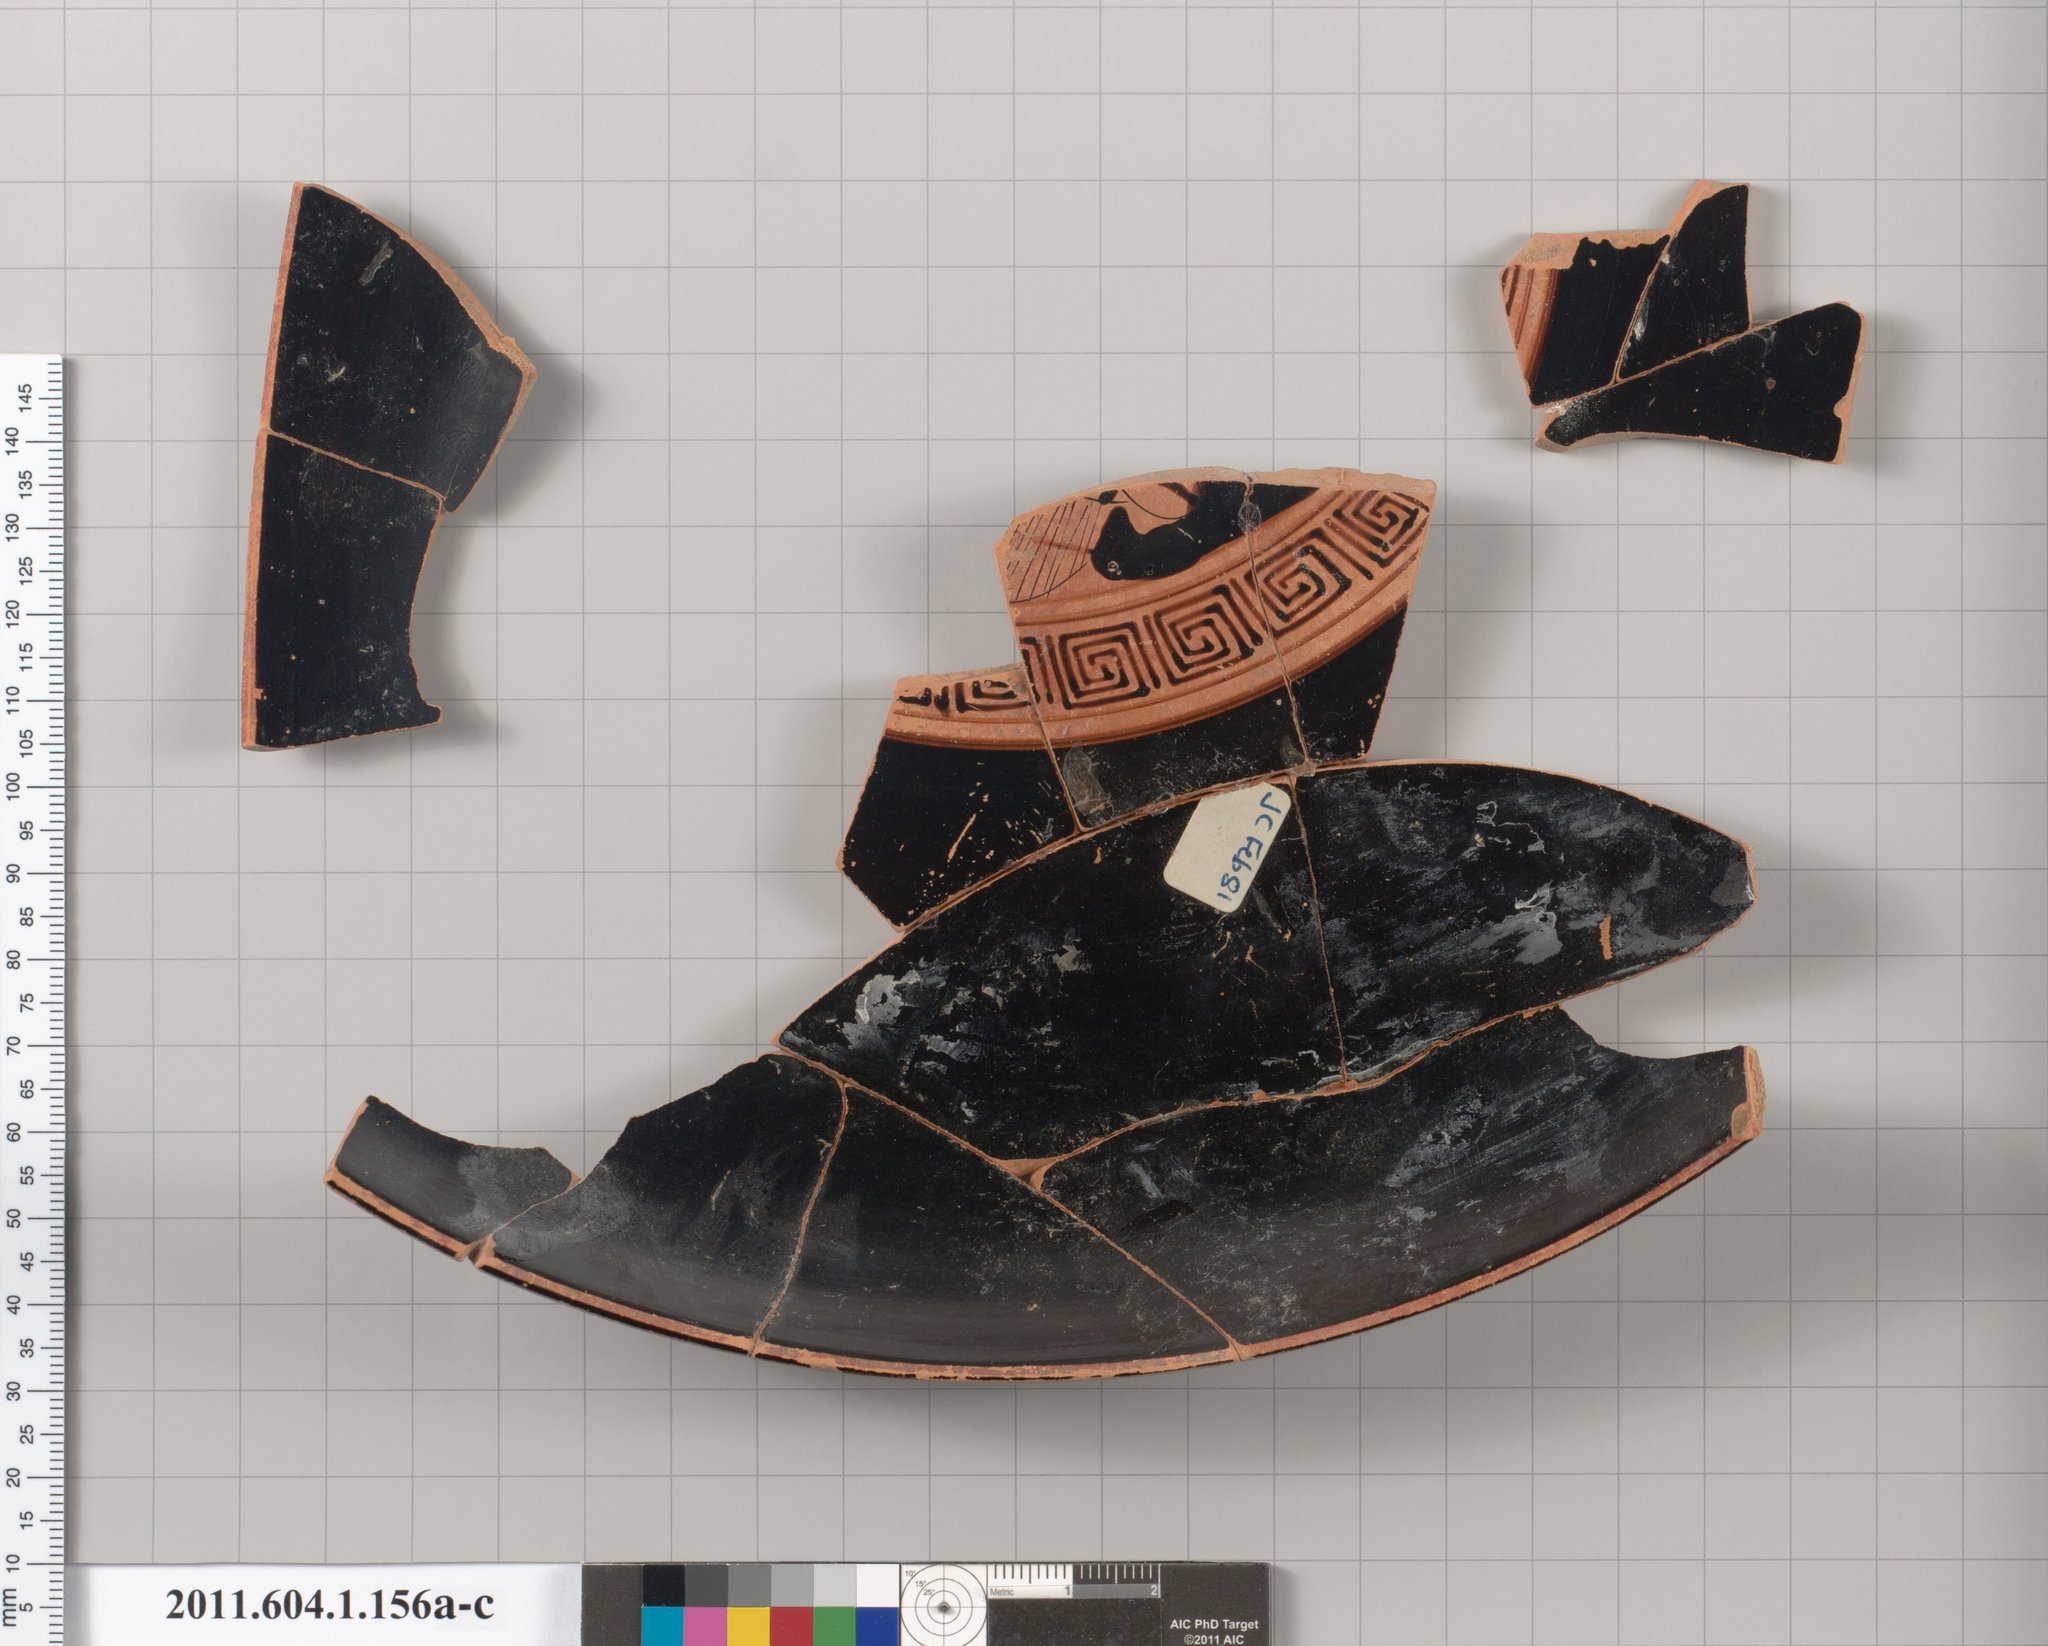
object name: kylix fragment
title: Terracotta fragment of a kylix (drinking cup)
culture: greek, attic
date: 475-451 BCE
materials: terracotta